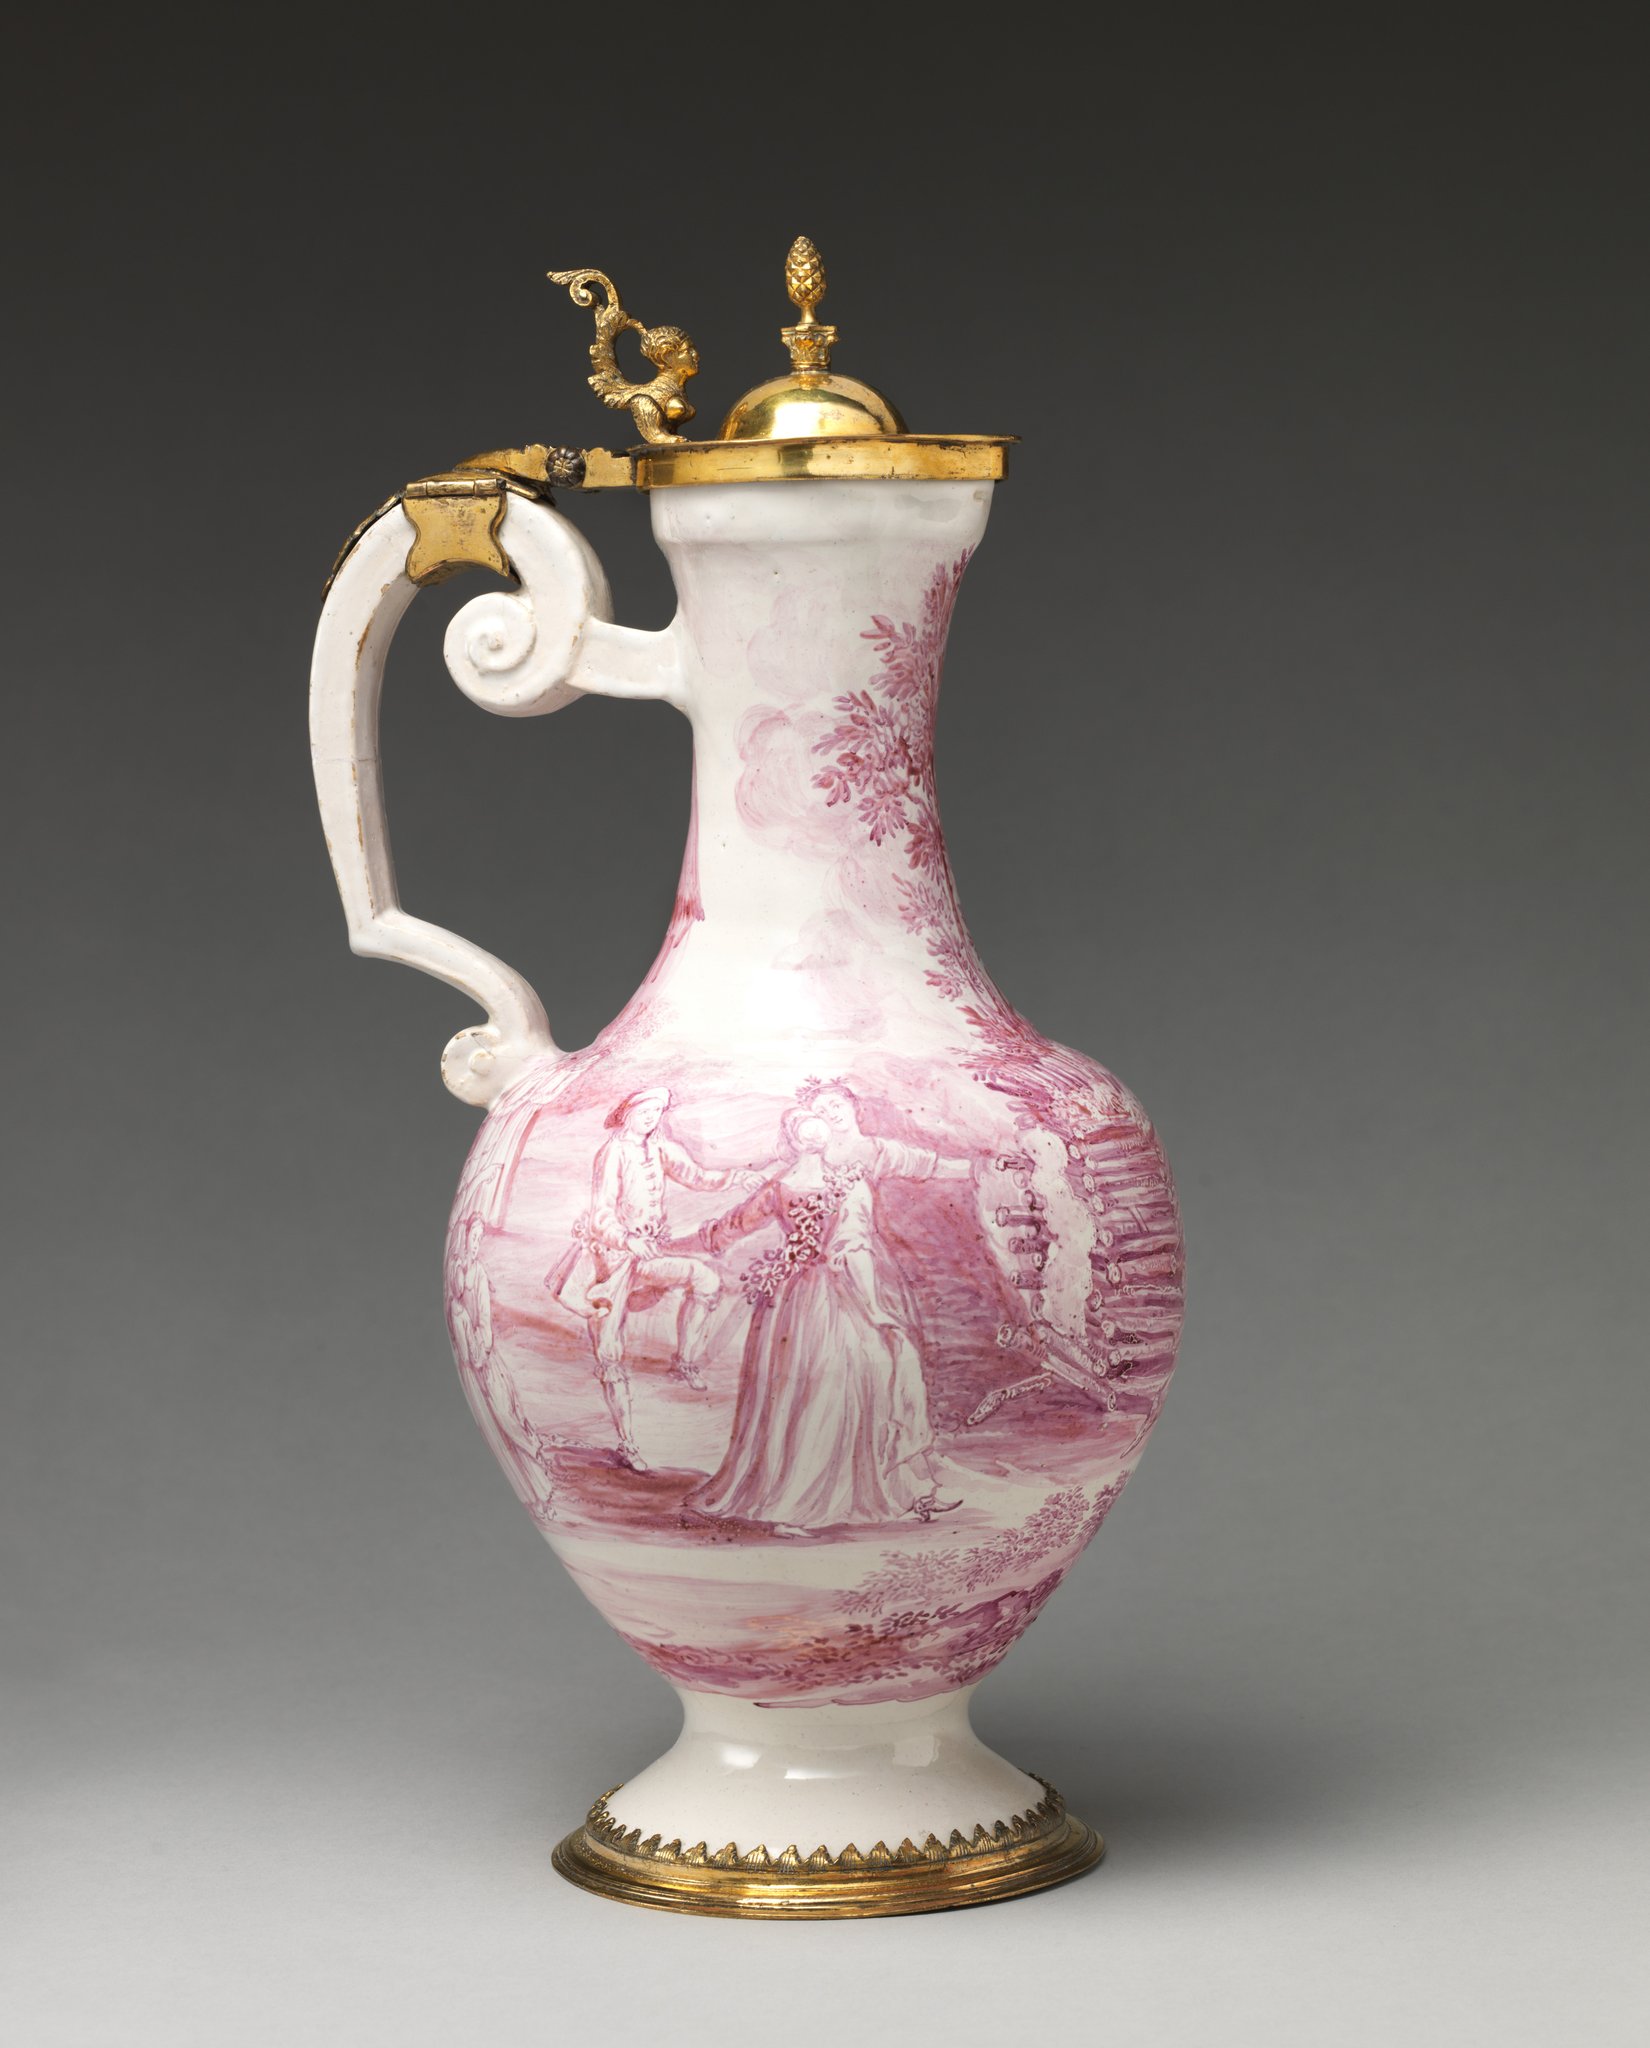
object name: jug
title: Jug (one of a pair)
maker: fehr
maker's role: maker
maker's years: 1650-1750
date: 1680-1690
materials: brass, earthenware, gilt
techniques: glazing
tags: men,women,trees